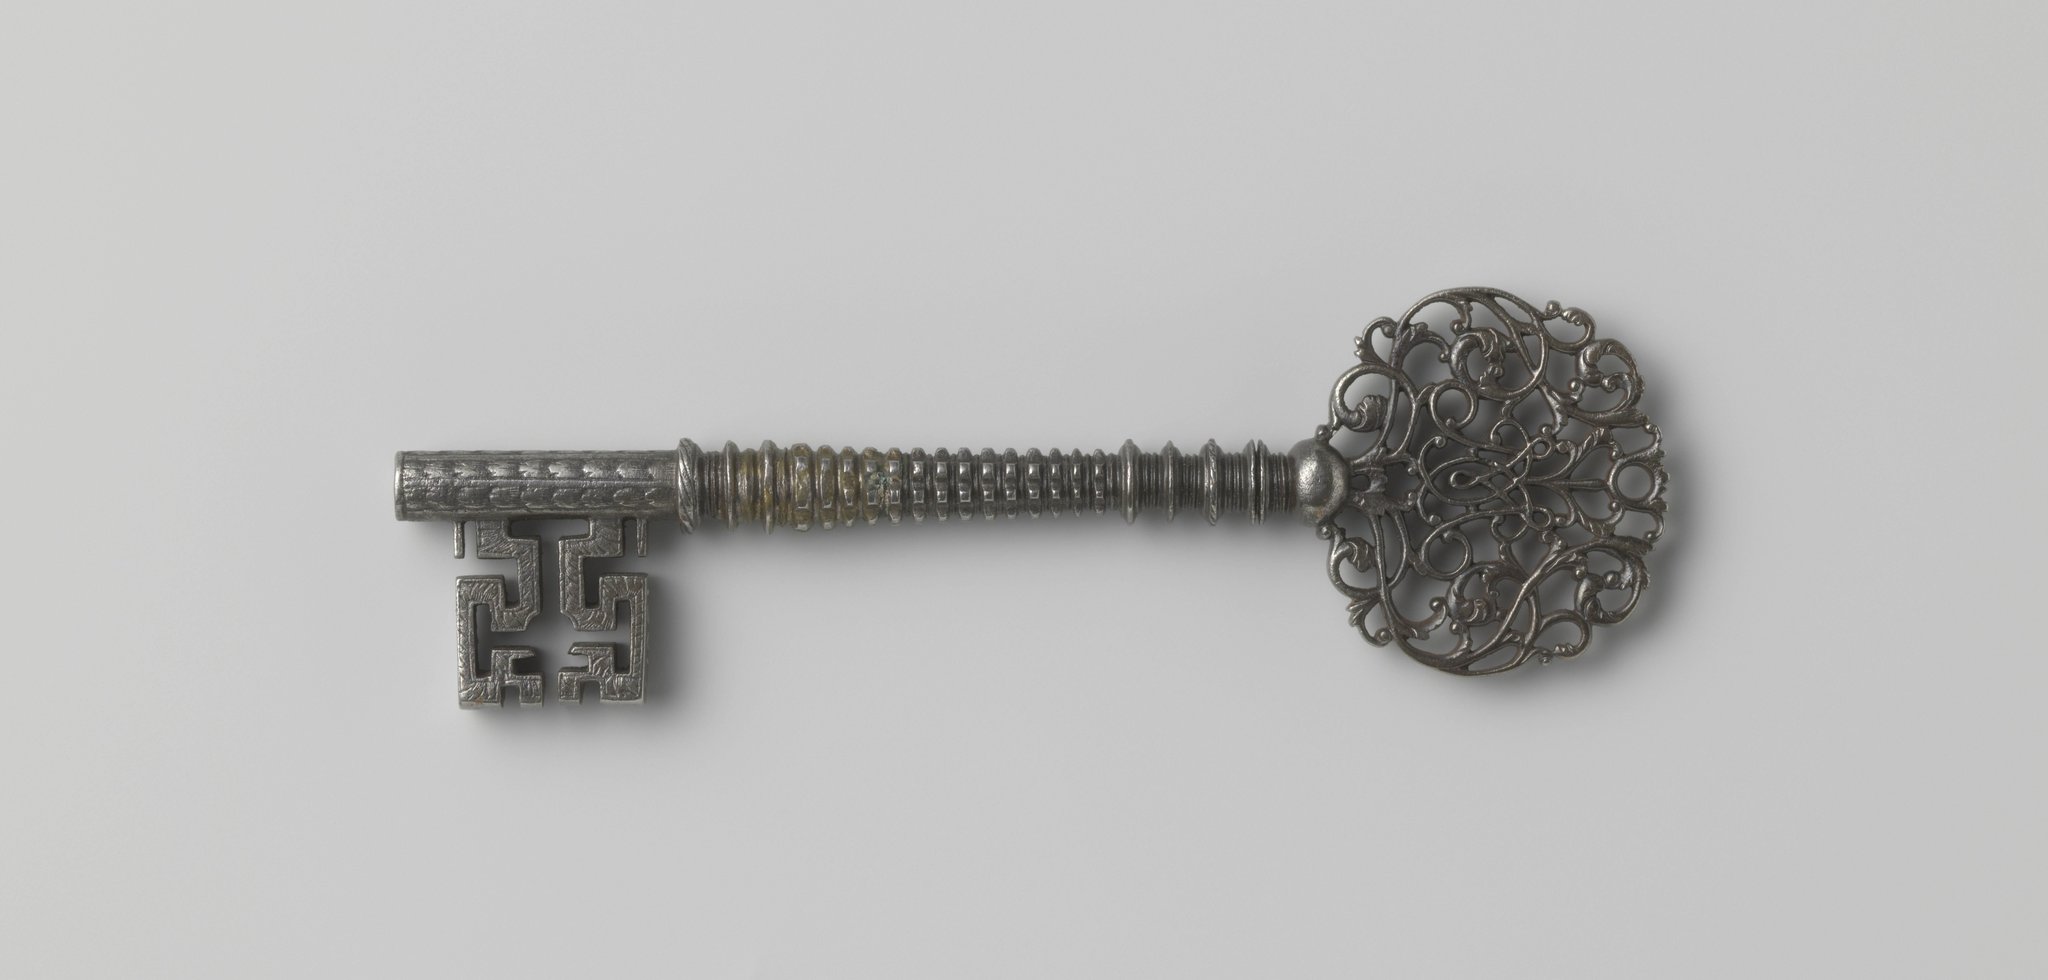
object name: key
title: Sleutel van ijzer met monogram MC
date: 1680-1700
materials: iron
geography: england